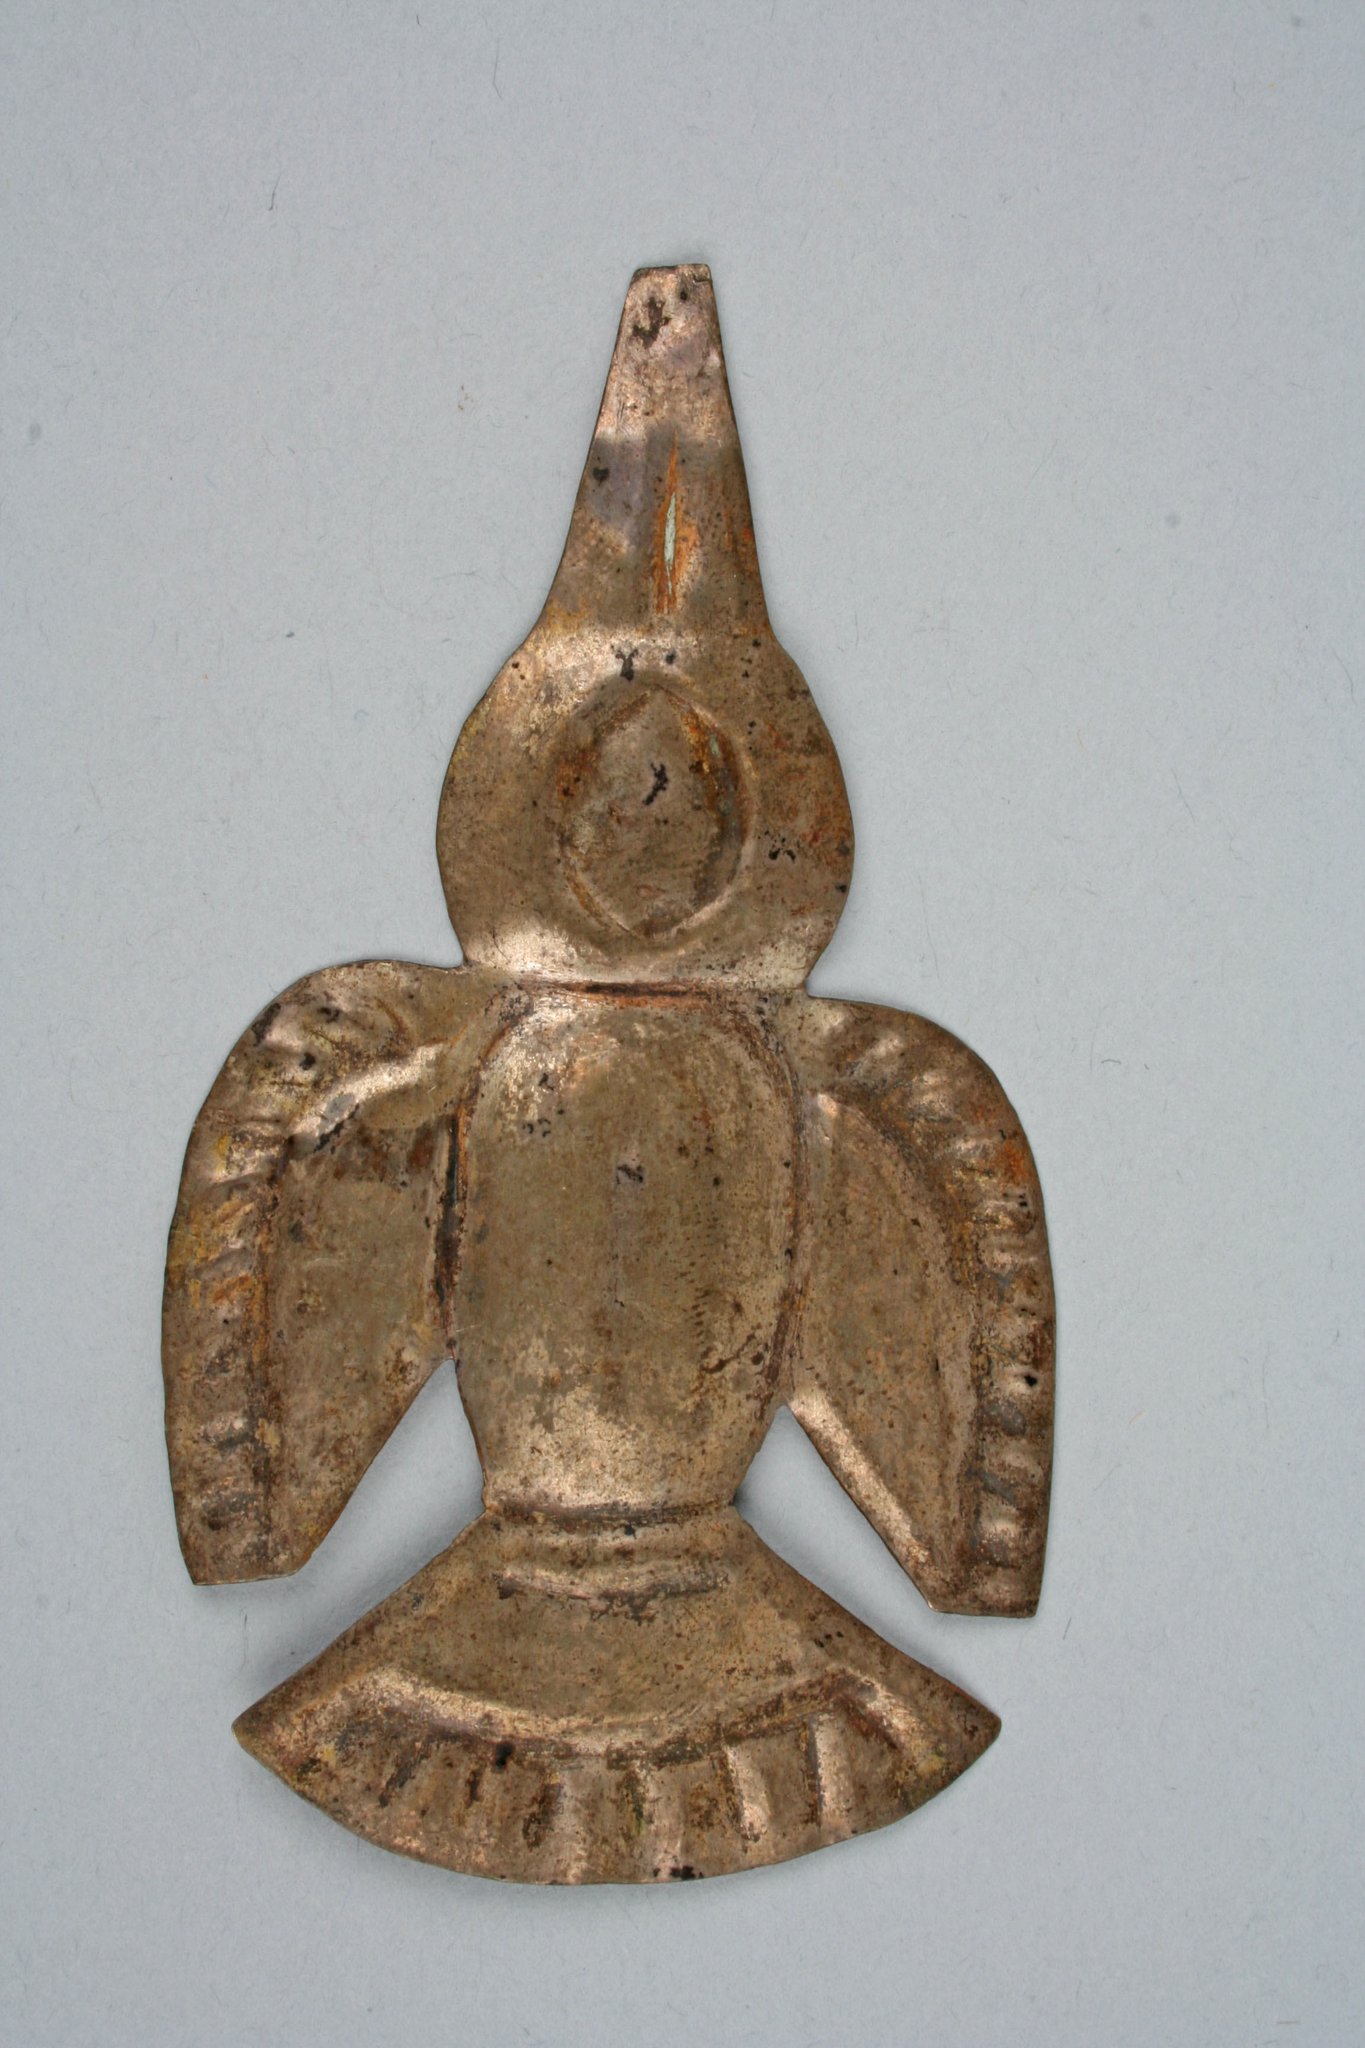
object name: ornament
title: Costume Ornament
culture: chimú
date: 1101-1500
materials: silver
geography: peru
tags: birds